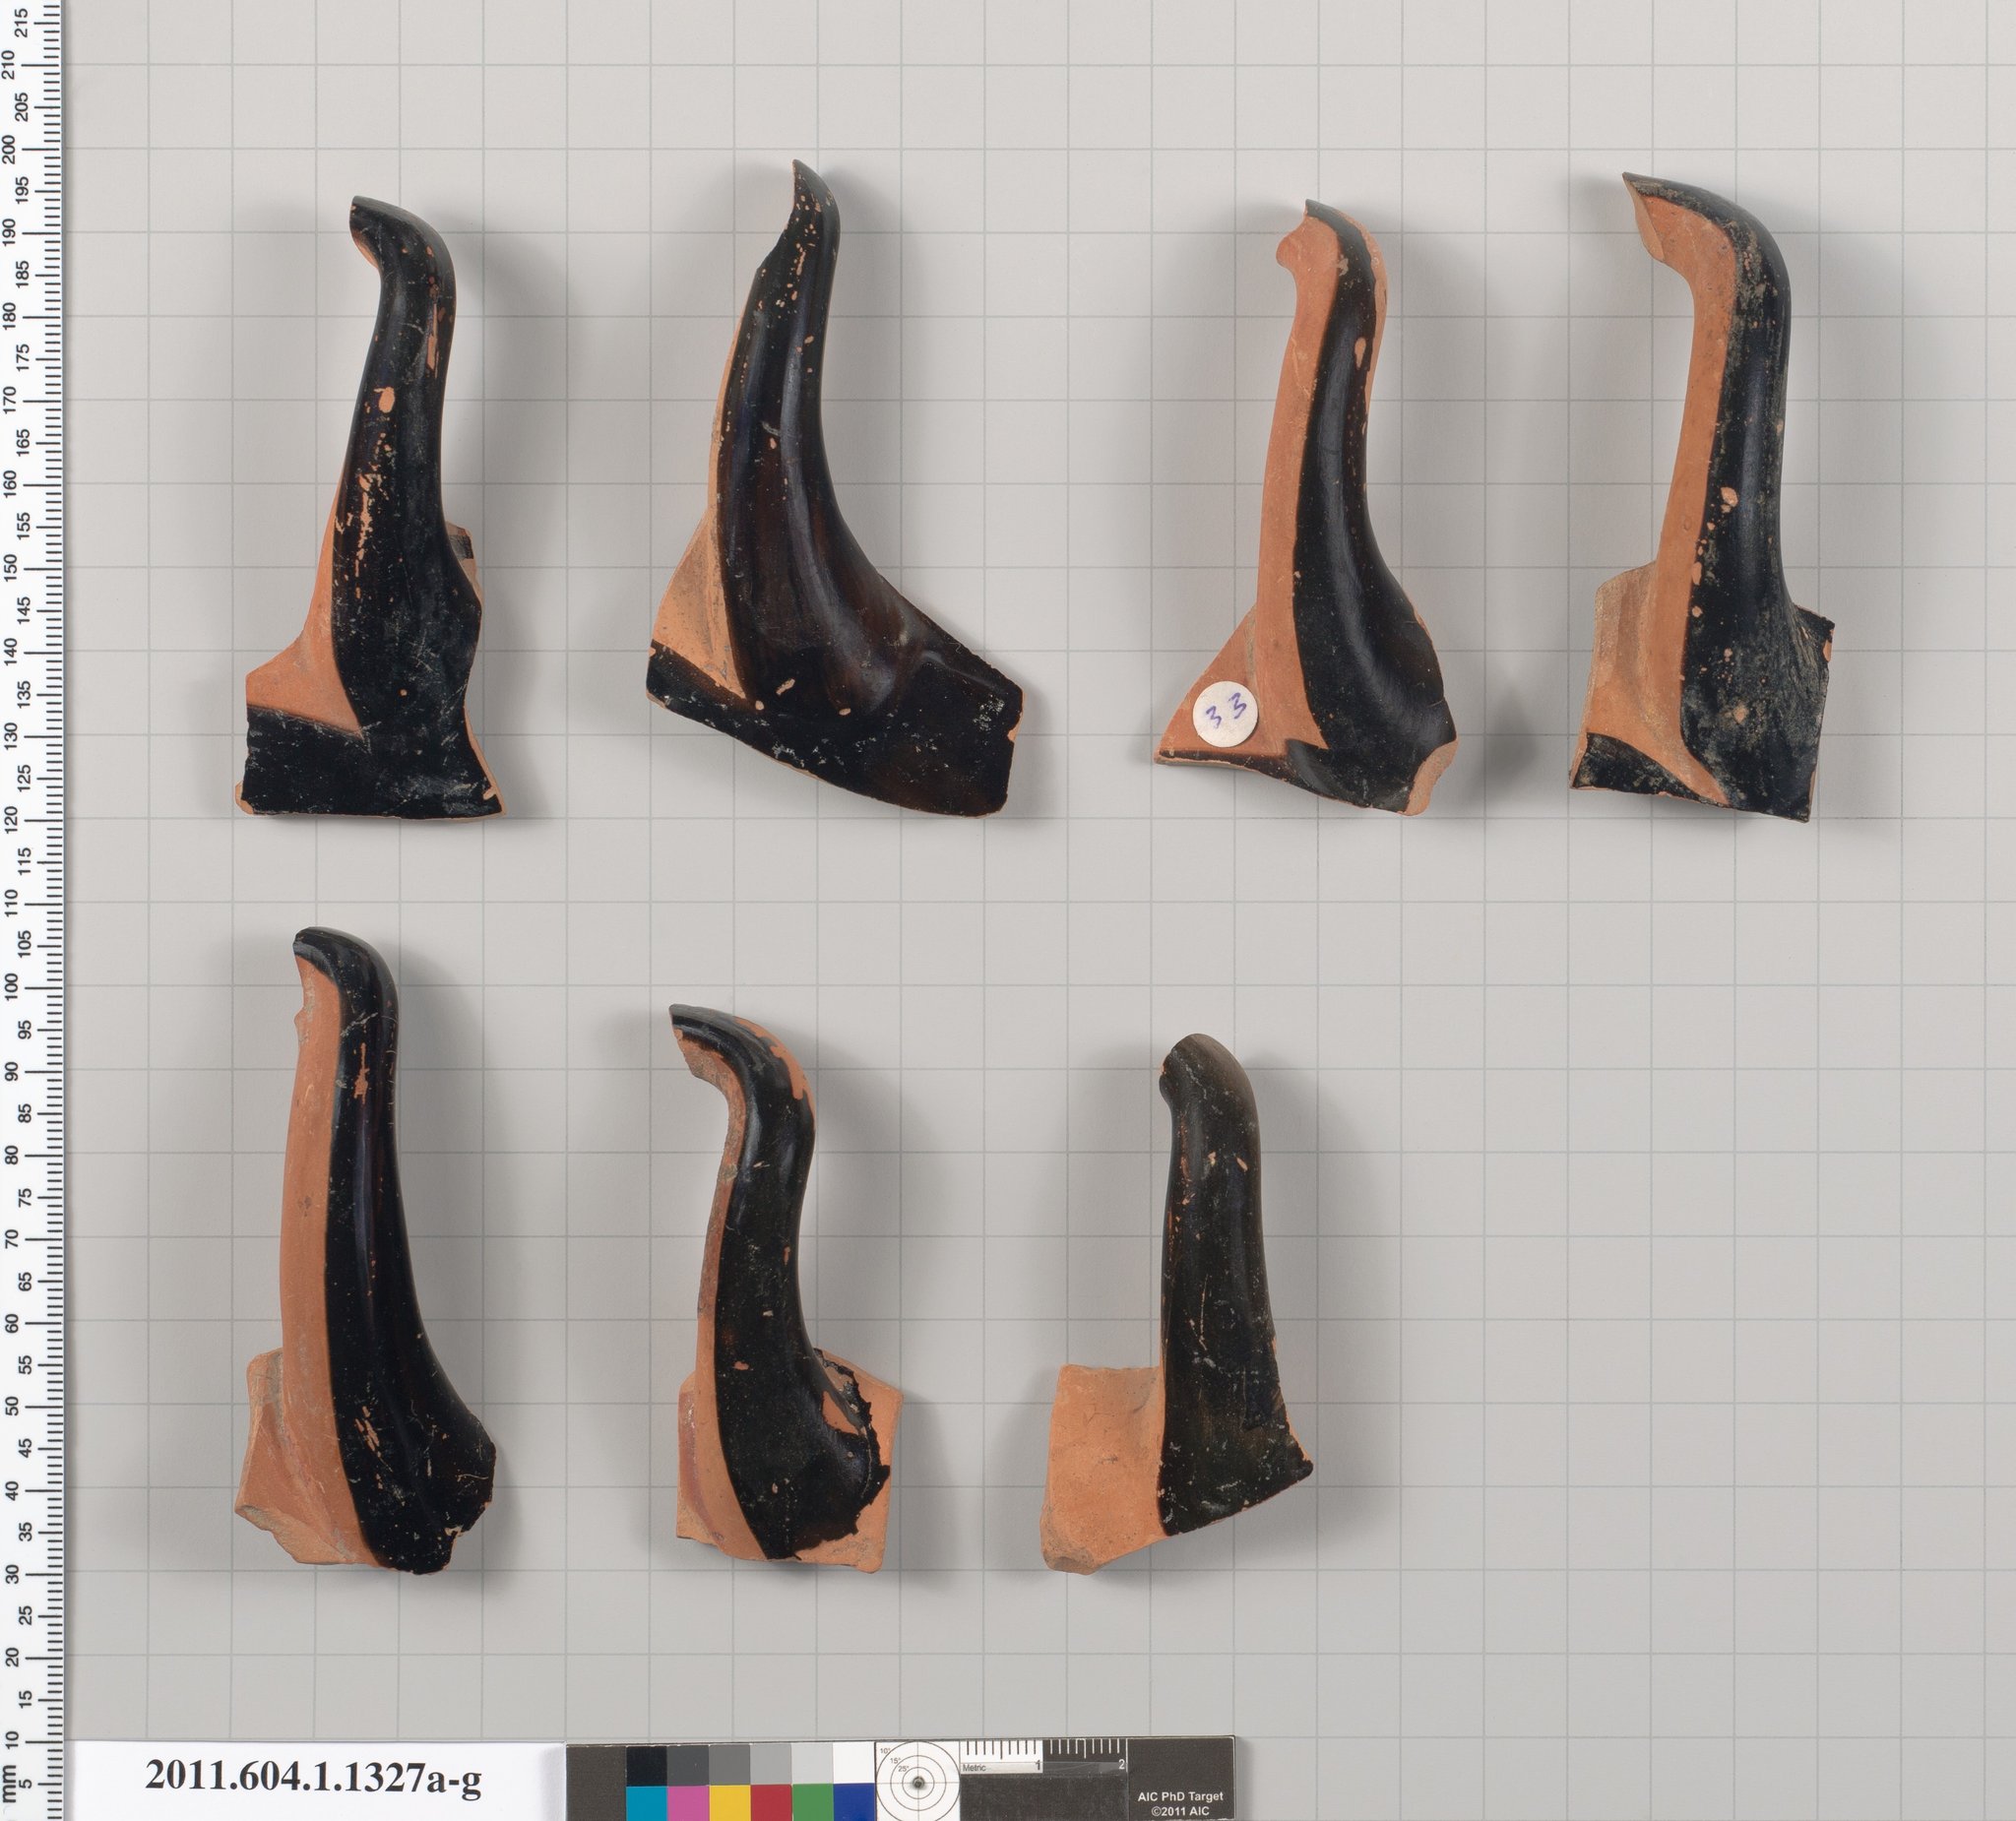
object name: kylix fragment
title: Terracotta fragments of kylikes (drinking cups)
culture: greek, attic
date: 500-401 BCE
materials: terracotta